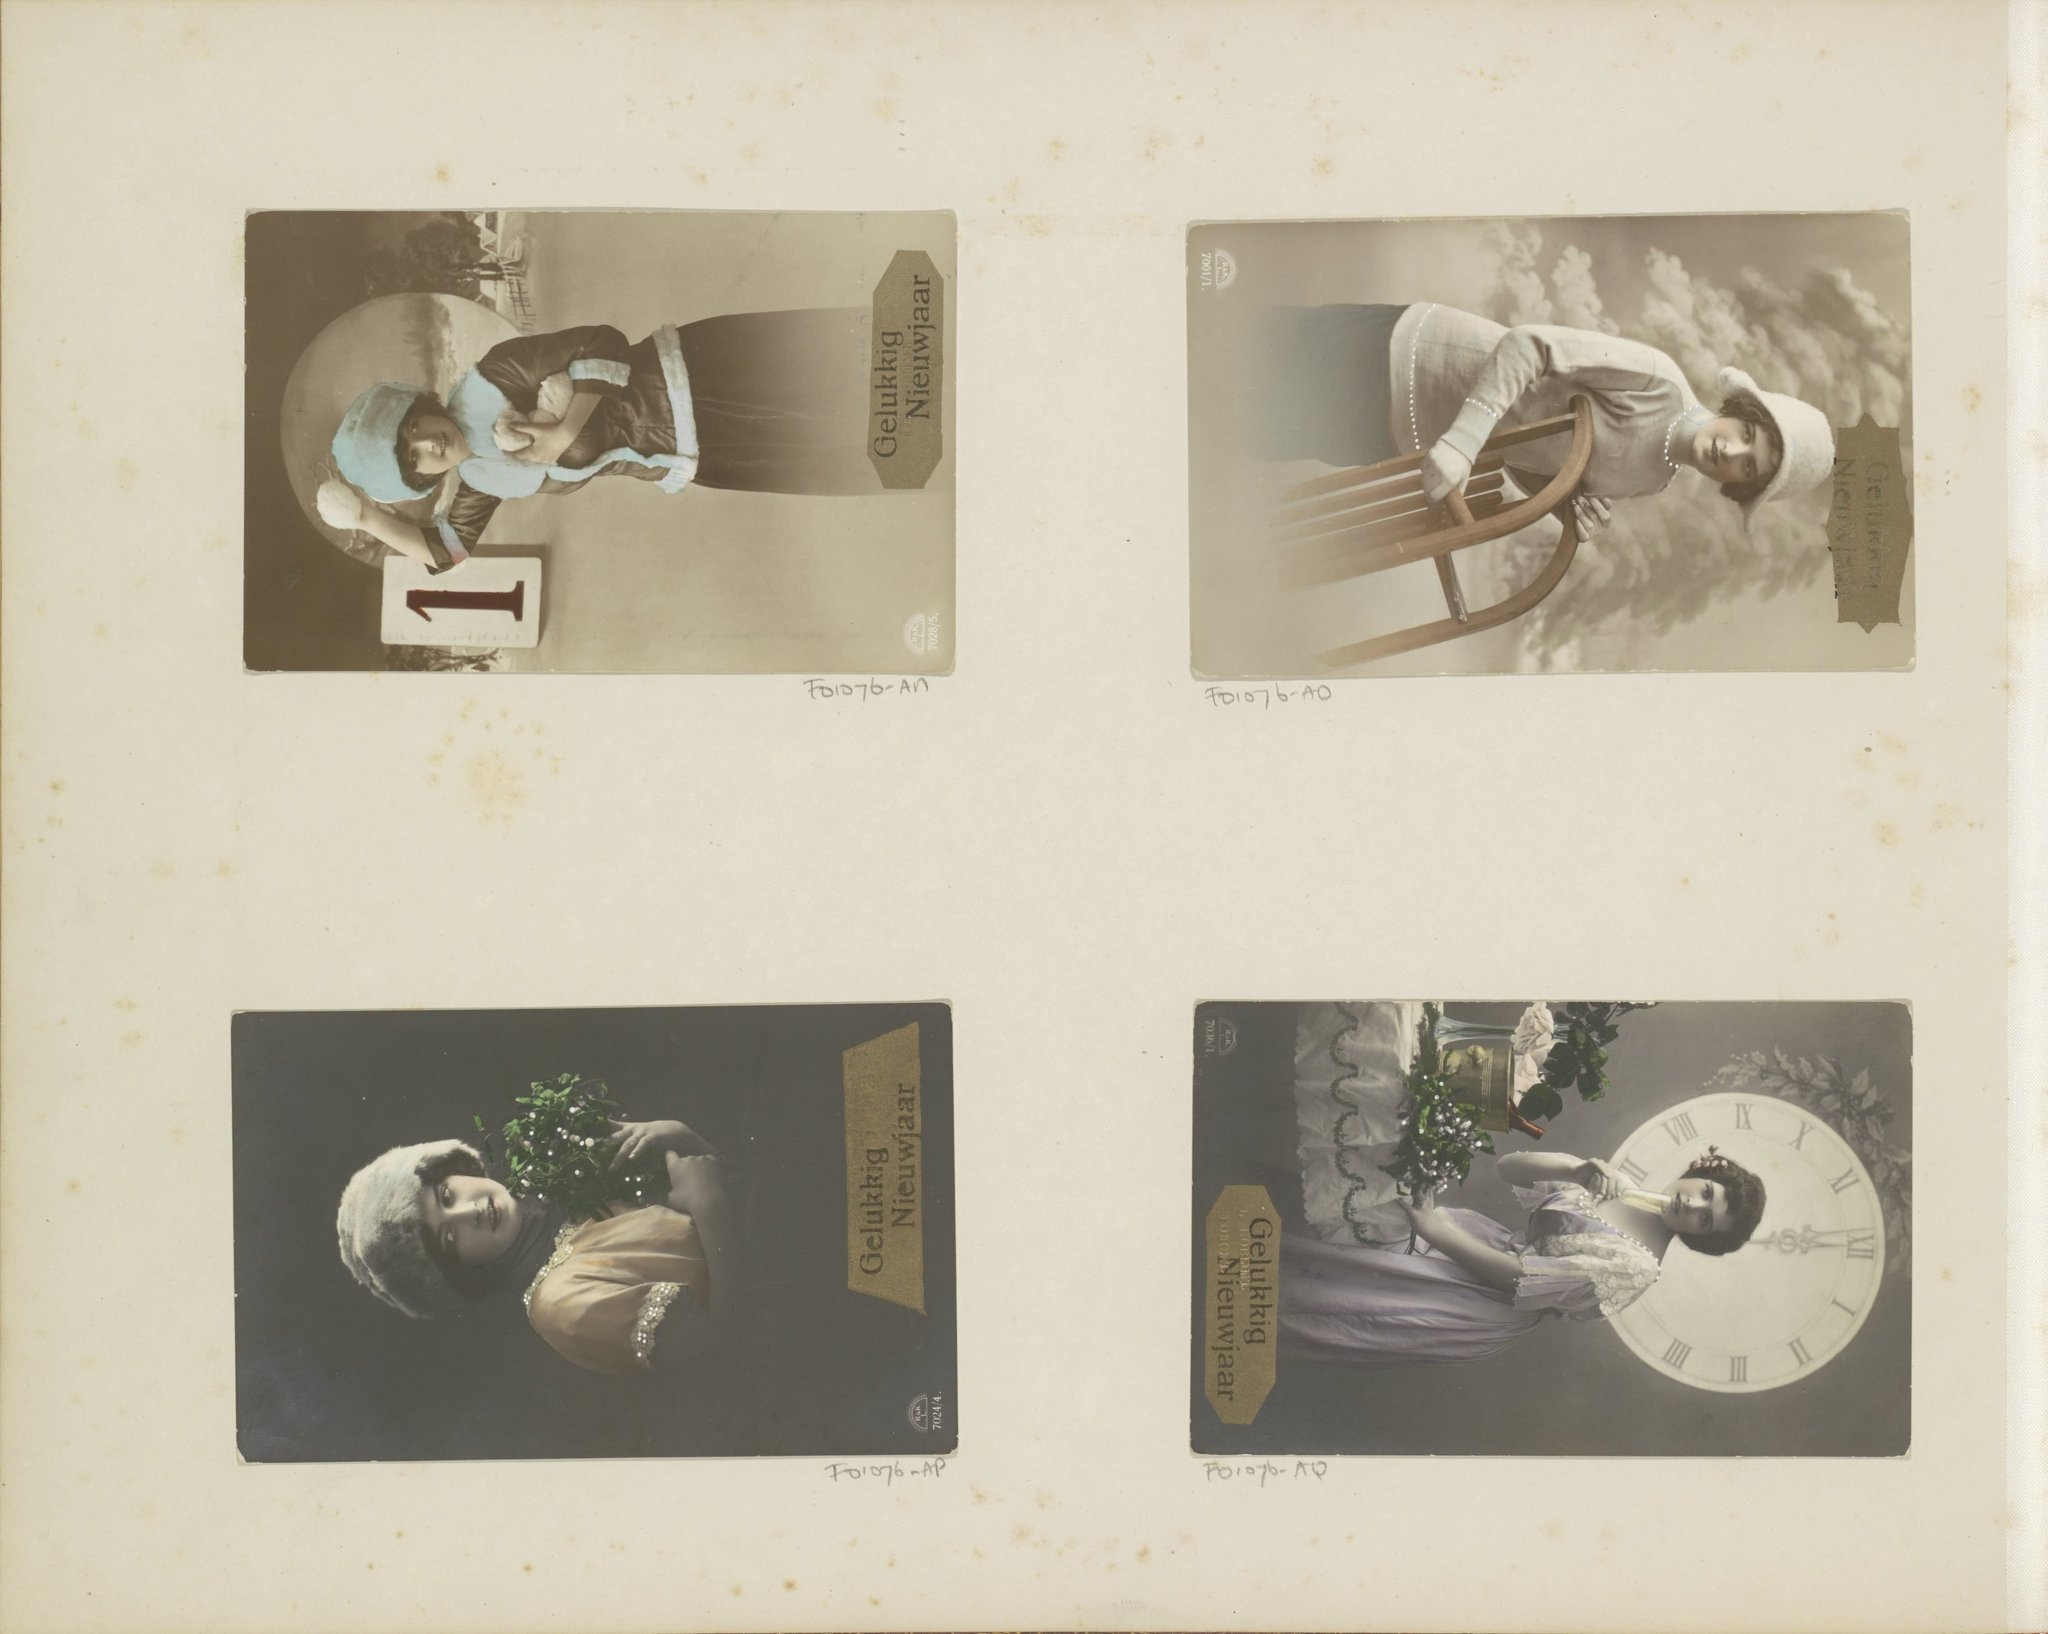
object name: ansichtkaart, prentbriefkaart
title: Nieuwjaarskaart met een portret van een vrouw bij een klok en een tafel met champagne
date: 1910-1940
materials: cardboard, paper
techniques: gelatin silver print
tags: adult woman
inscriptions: number: ‘7036/1.’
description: Onderdeel van Album met foto's van spoorwegen in Nederlands-Indië en prentbriefkaarten.